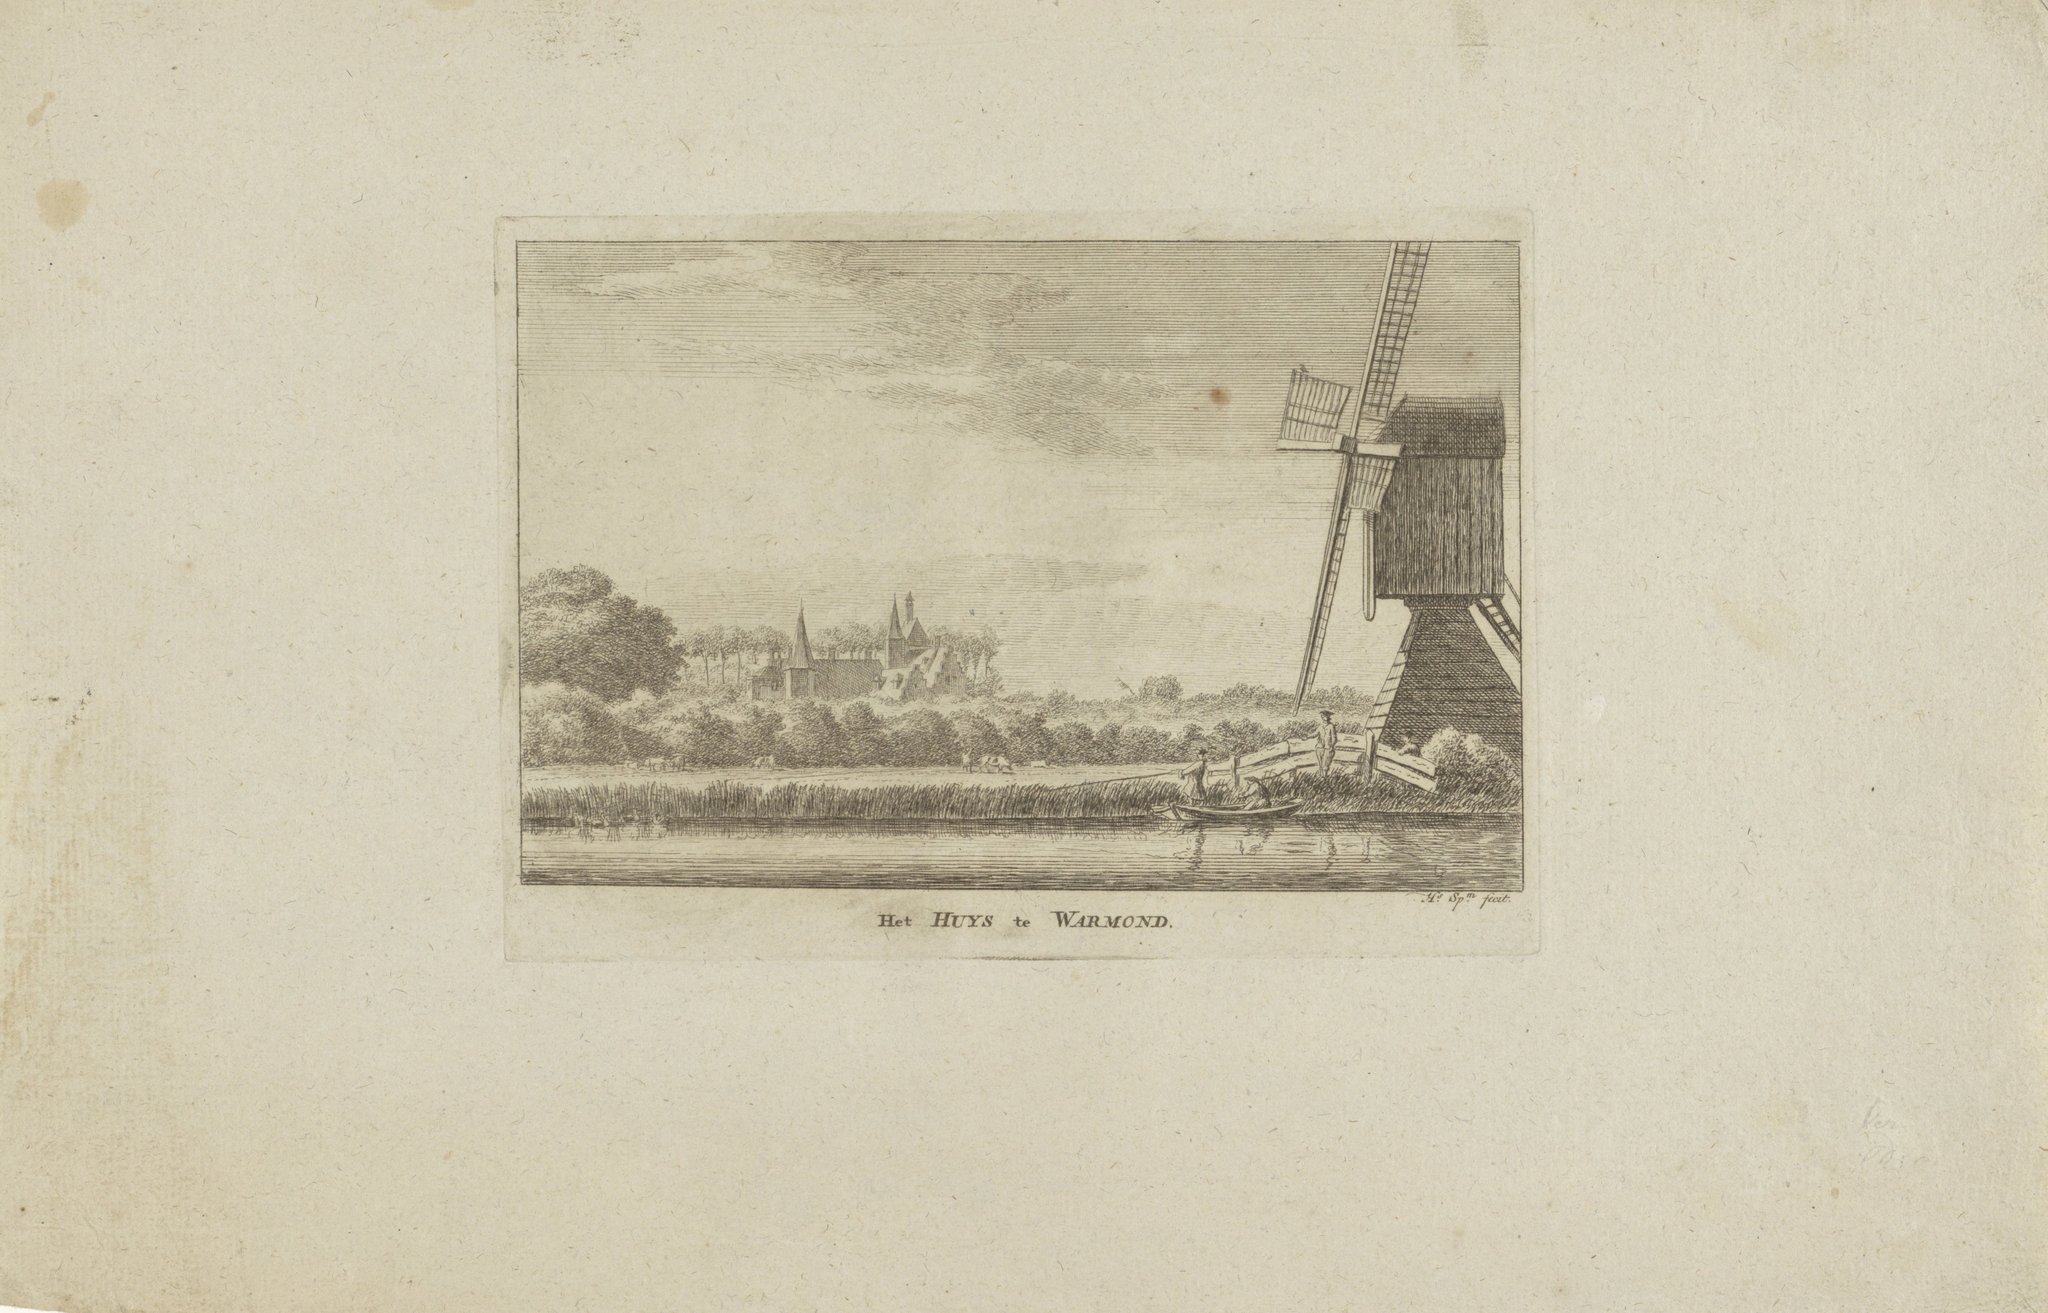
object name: print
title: Gezicht op Huis Warmond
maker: hendrik spilman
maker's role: draughtsman, painter, print maker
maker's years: 1721-1784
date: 1742-1784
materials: paper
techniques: etching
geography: haarlem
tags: windmill in landscape, landscape with tower or castle, windmill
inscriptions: collector's mark: Lugt 2228